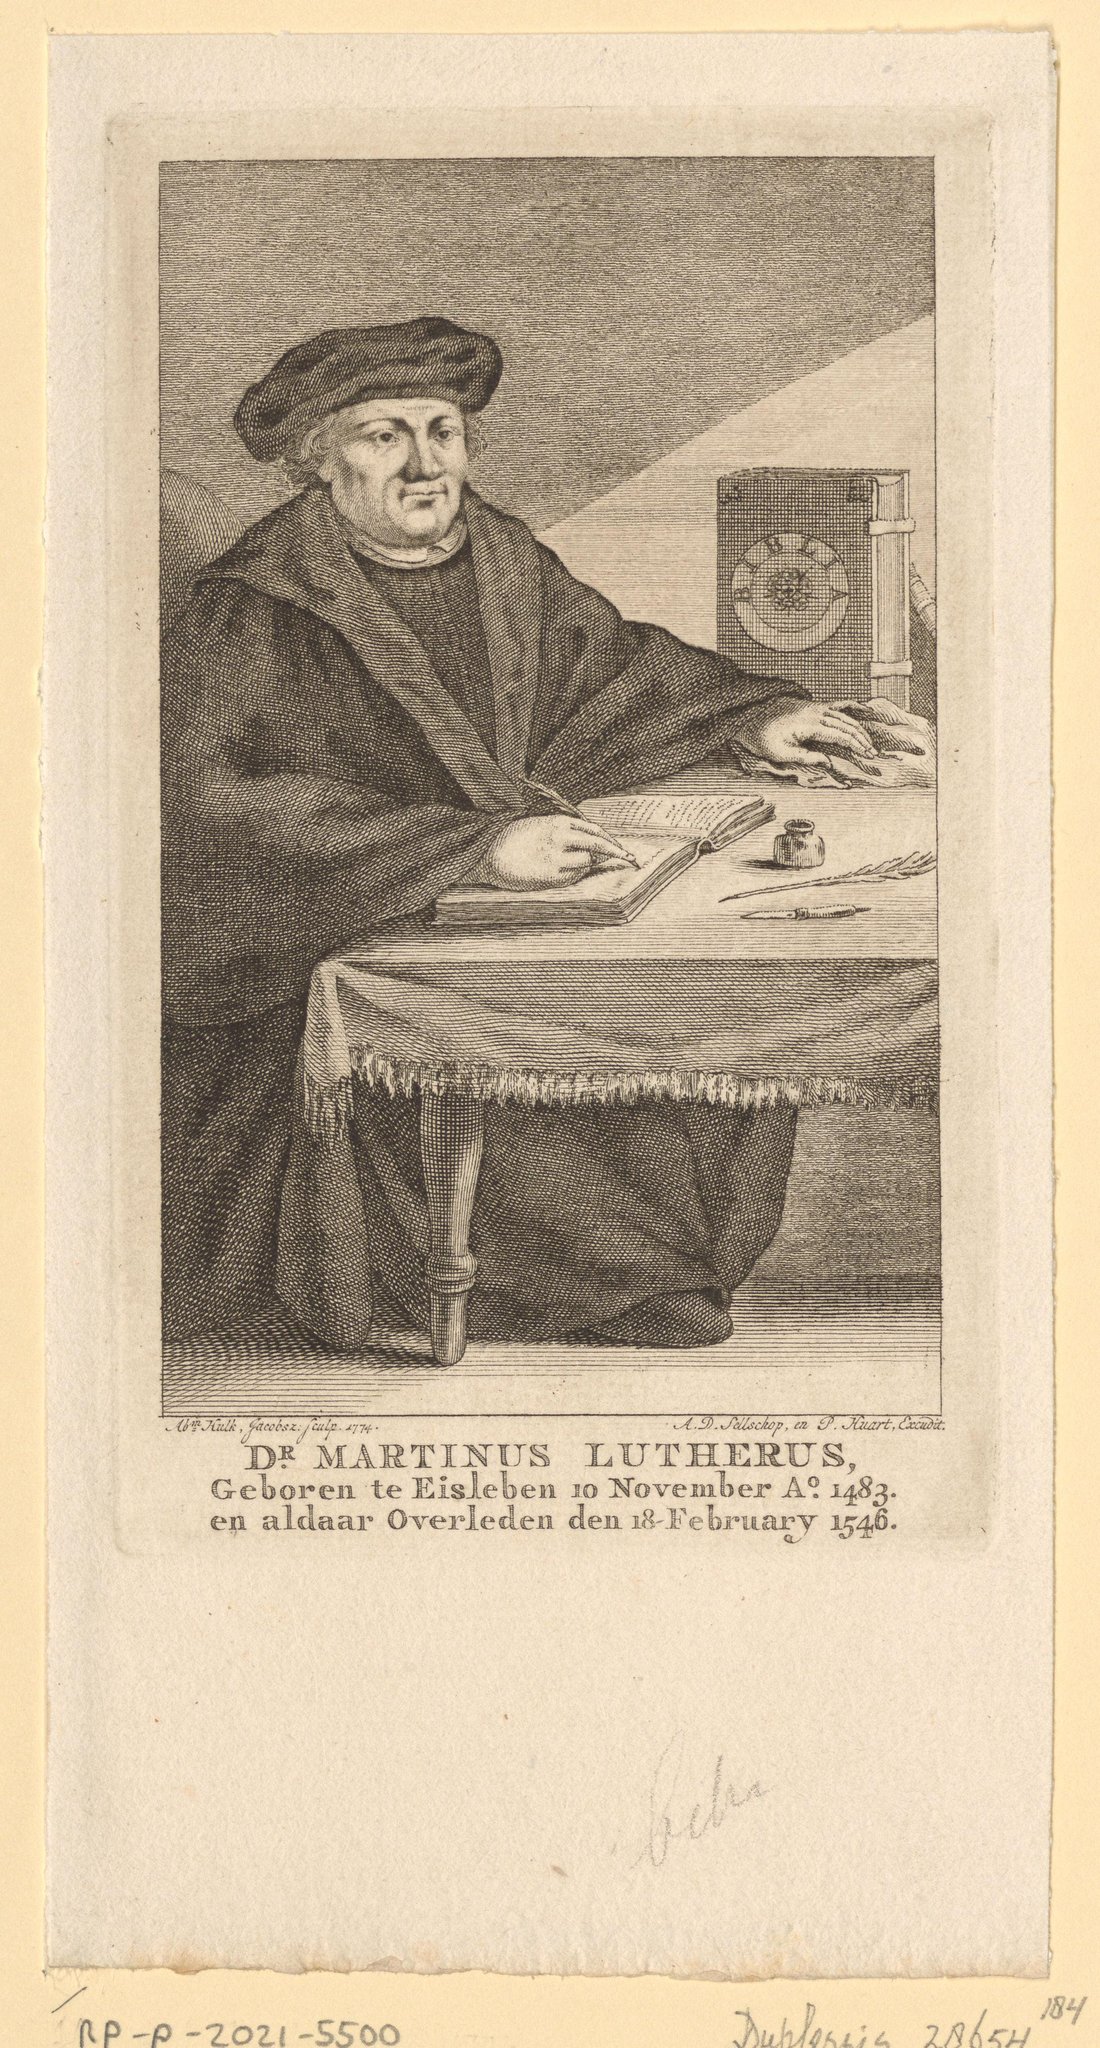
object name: print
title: Portret van Martin Luther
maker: abraham jacobsz. hulk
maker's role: print maker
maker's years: 1751-1817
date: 1774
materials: paper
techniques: etching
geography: amsterdam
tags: priest, martin luther, handwriting, writing as activity, theologian, historical persons, the bible as a book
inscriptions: date